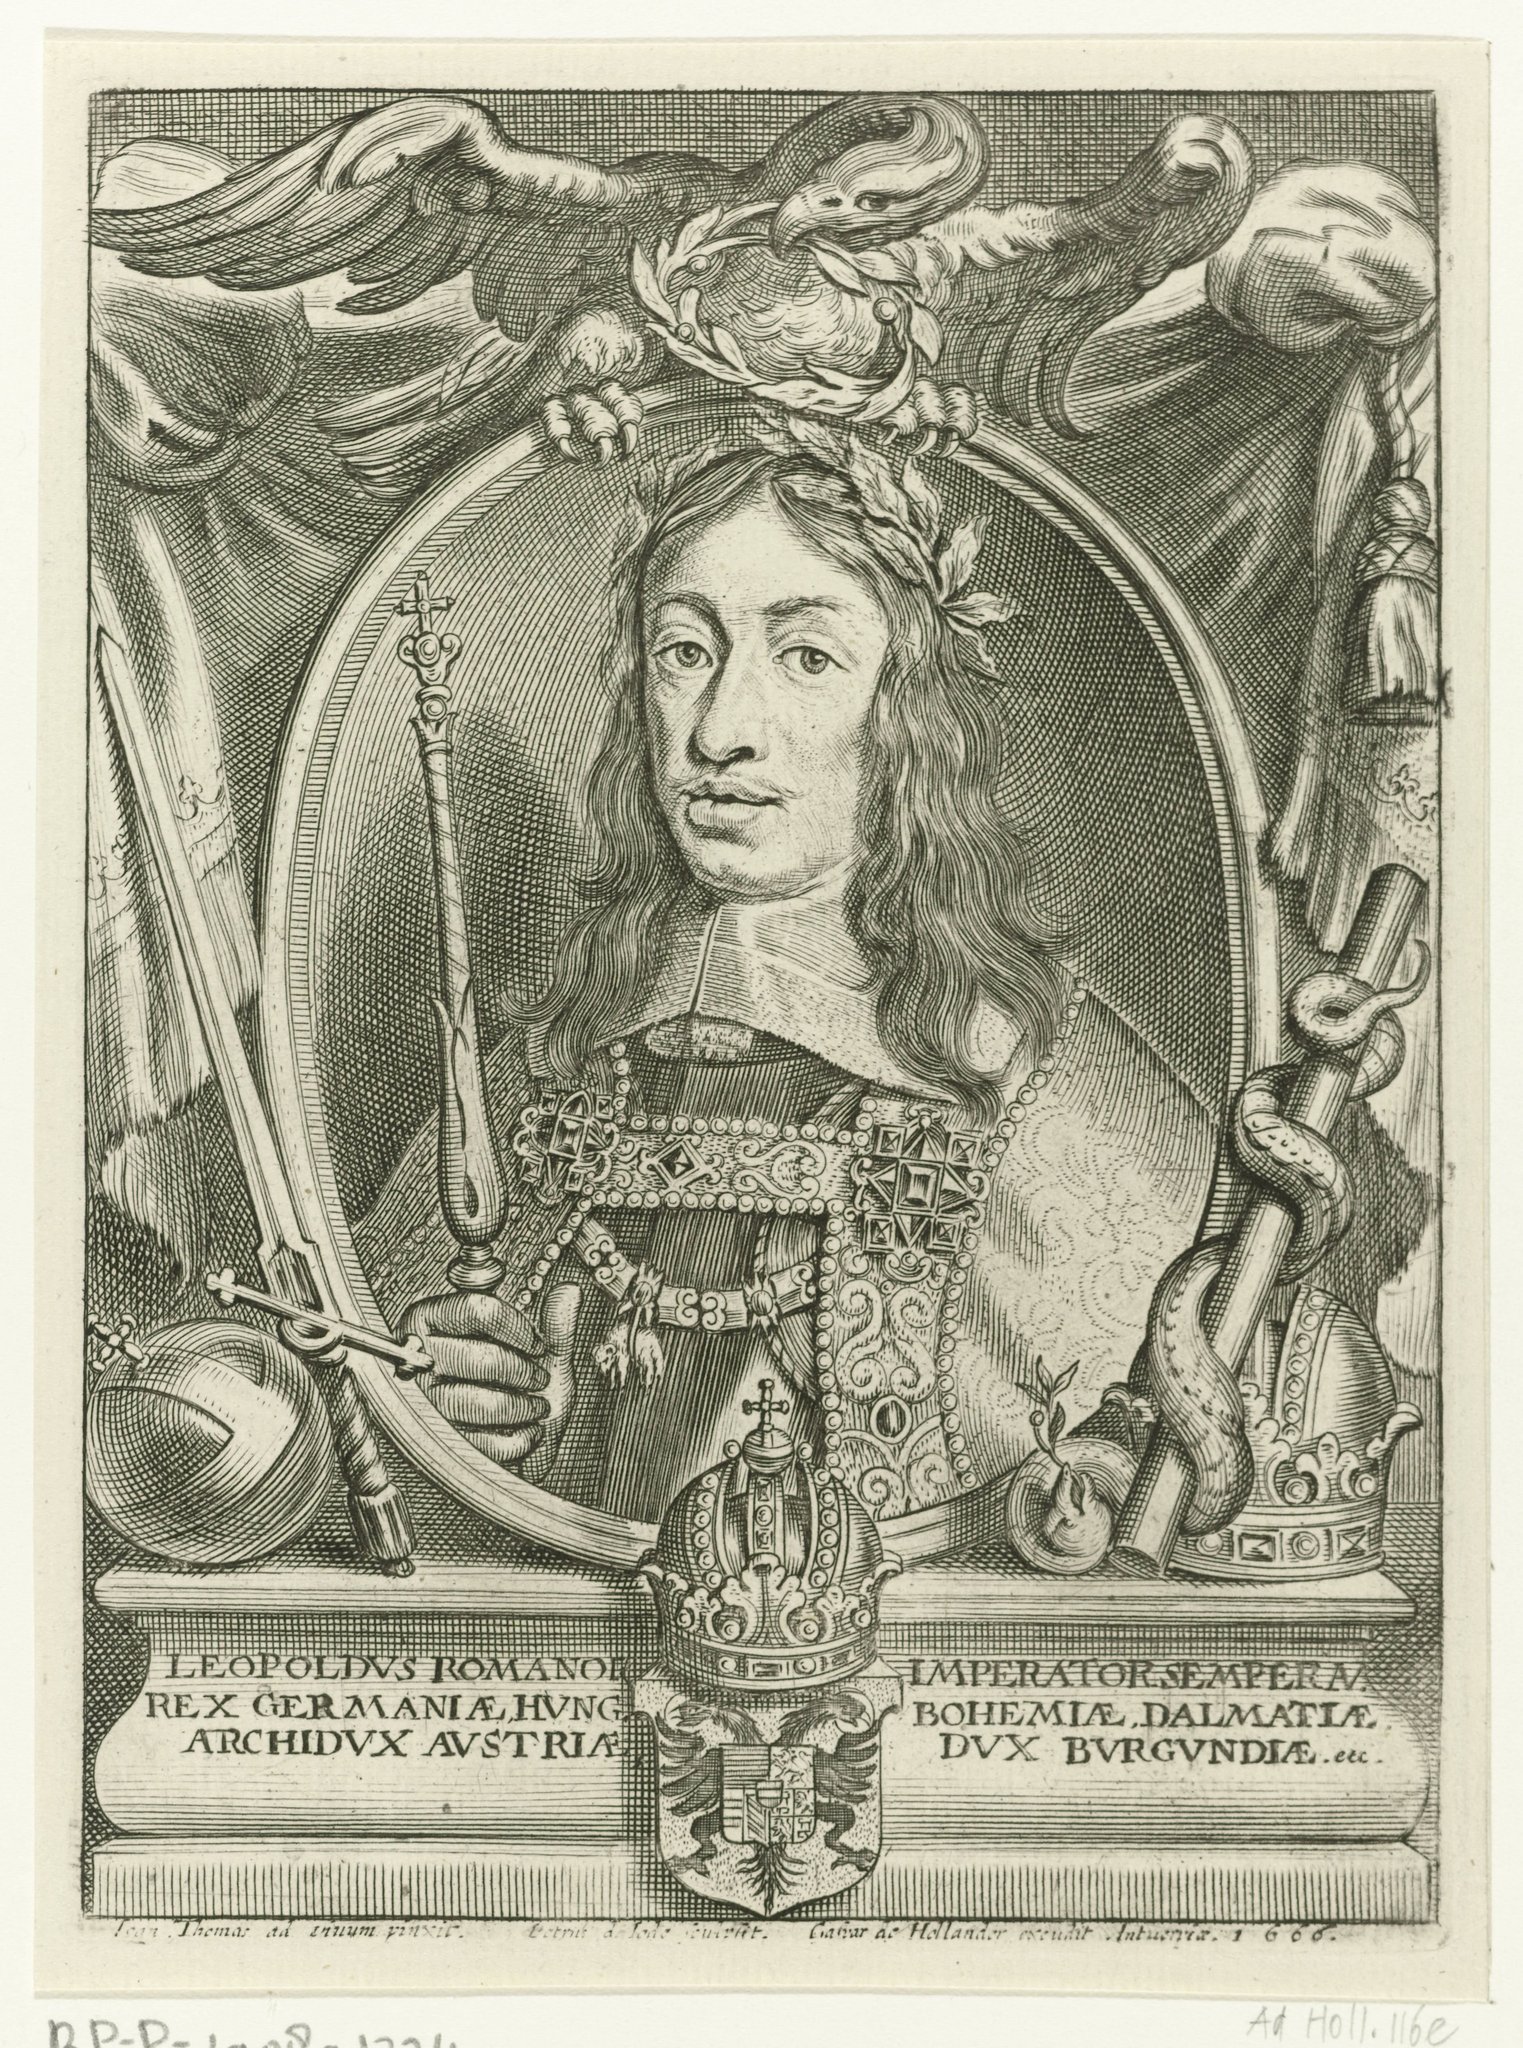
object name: print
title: Theatrum pontificum, imperatorum, regum, ducum, principum, etc.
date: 1666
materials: paper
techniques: engraving, etching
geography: antwerp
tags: leopold i (keizer van duitsland), crown (symbol of sovereignty), predatory birds: eagle, hacking and thrusting weapons: sword, knighthood order of the golden fleece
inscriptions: collector's mark: Lugt 2228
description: Busteportret van Leopold I, in rijk gedecoreerde mantel. Hij is gekroond met een lauwerkrans en draagt een keten met de Orde van het Gulden Vlies. In zijn rechterhand houdt hij een scepter. Het portret is gevat in een ovale omlijsting op een piëdestal. Bovenop de omlijsting een adelaar met lauwerkrans in zijn snavel. Op het piëdestal een rijksappel, zwaard, commandostaf met slang en een kroon en het wapenschild van de geportretteerde en een drieregelig onderschrift in het Latijn.